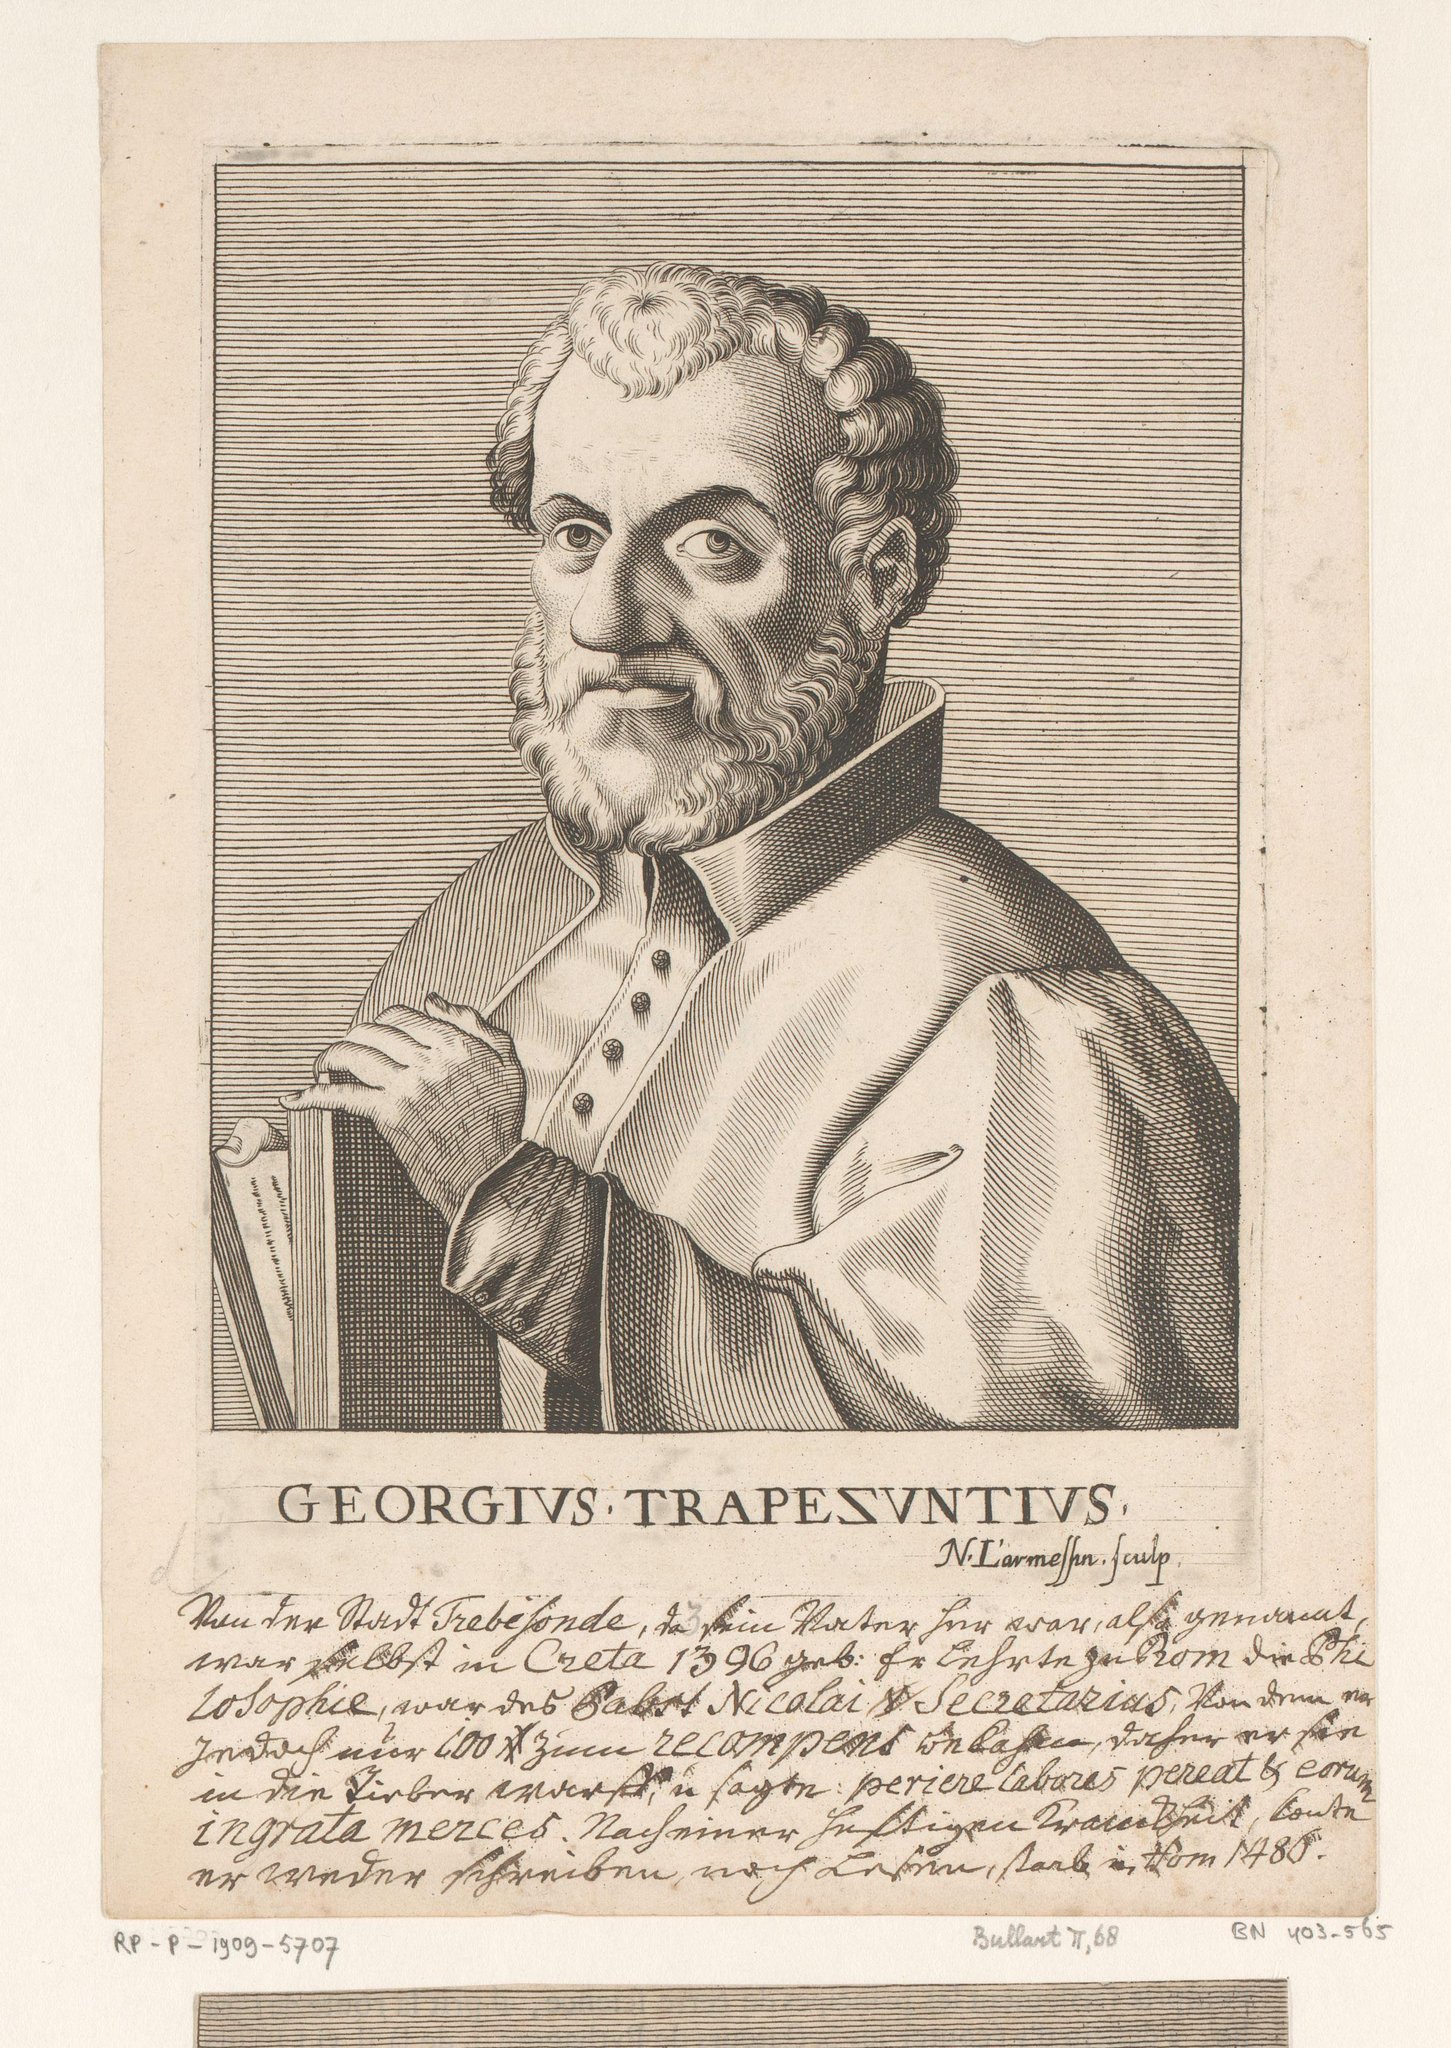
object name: book illustration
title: Georgius Trapezuntius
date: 1682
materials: paper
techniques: engraving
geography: brussels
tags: rome, scholar, philosopher, historical persons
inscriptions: inscription, collector's mark: Lugt 2228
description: Prent gebruikt voor: Bullart, Isaac. Académie des Sciences et Arts contenant les vies et éloges his. des hommes illustres qui ont excellé en ces professions depuis environ quatre siècles. Brussel: François Foppens, 1682. Het boek werd in 1682 eveneens in Amsterdam uitgegeven door de erfgenamen van Daniel Elzevier. Ieder portret betreft een illustratie bij de biografie van een kunstenaar of geleerde. De meeste portretten werden door Nicolas de Larmessin vervaardigd (162), 93 door De Boulonois en een derde door ongeïdentificeerde prentmakers. Dit betreft een illustratie op p. 68, deel II.